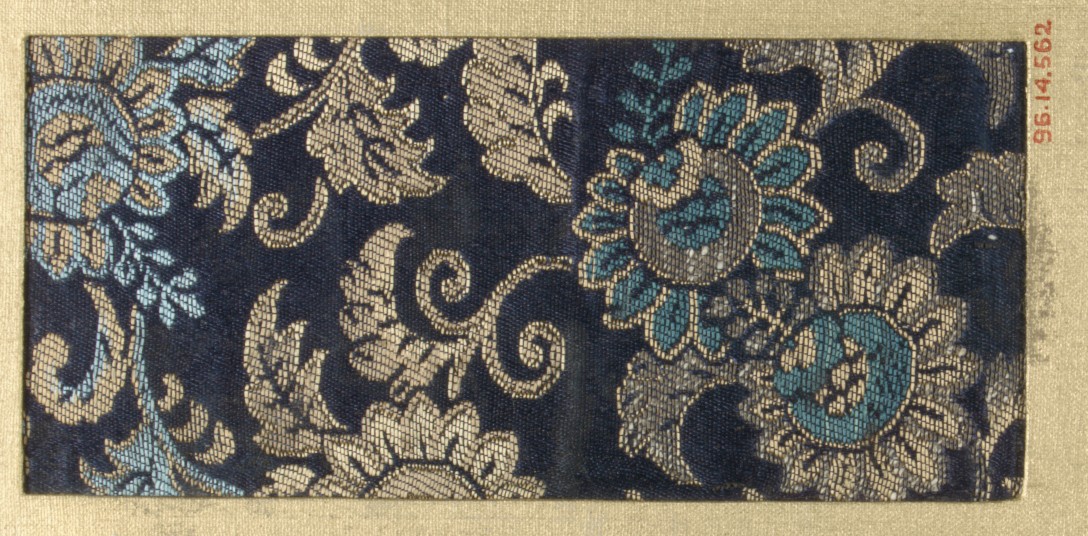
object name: piece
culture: japanese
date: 1701-1900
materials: silk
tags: leaves